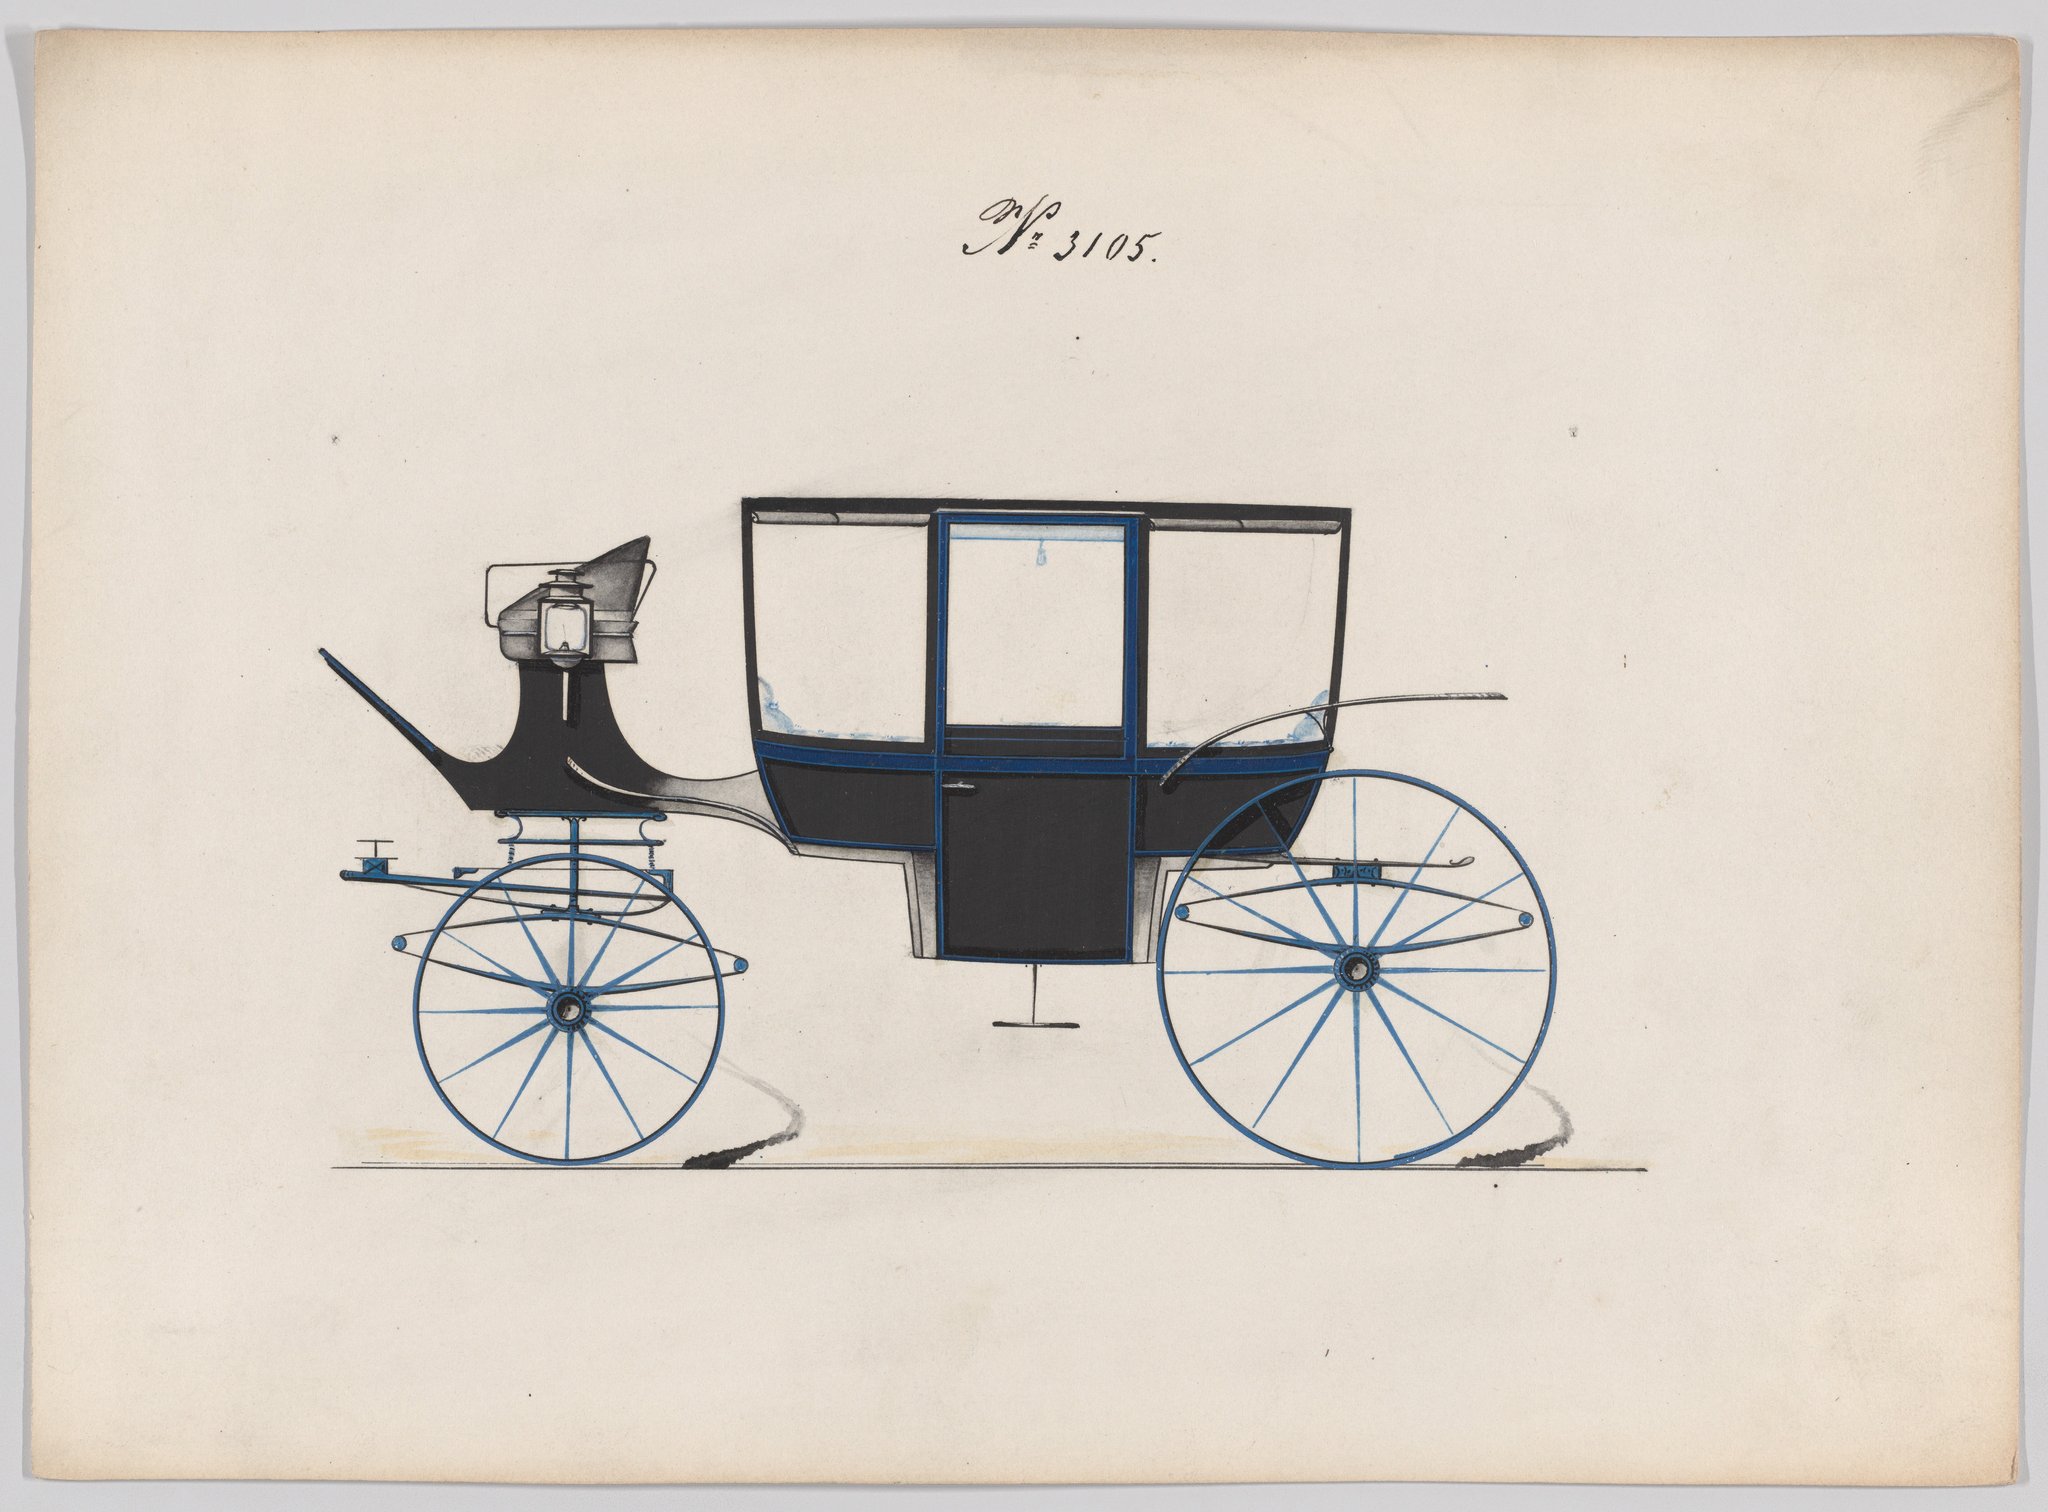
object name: drawing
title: Coach #3105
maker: brewster & co.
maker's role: manufacturer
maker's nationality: american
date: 1875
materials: gouache, gum arabic, ink, watercolor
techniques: pen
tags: carriages